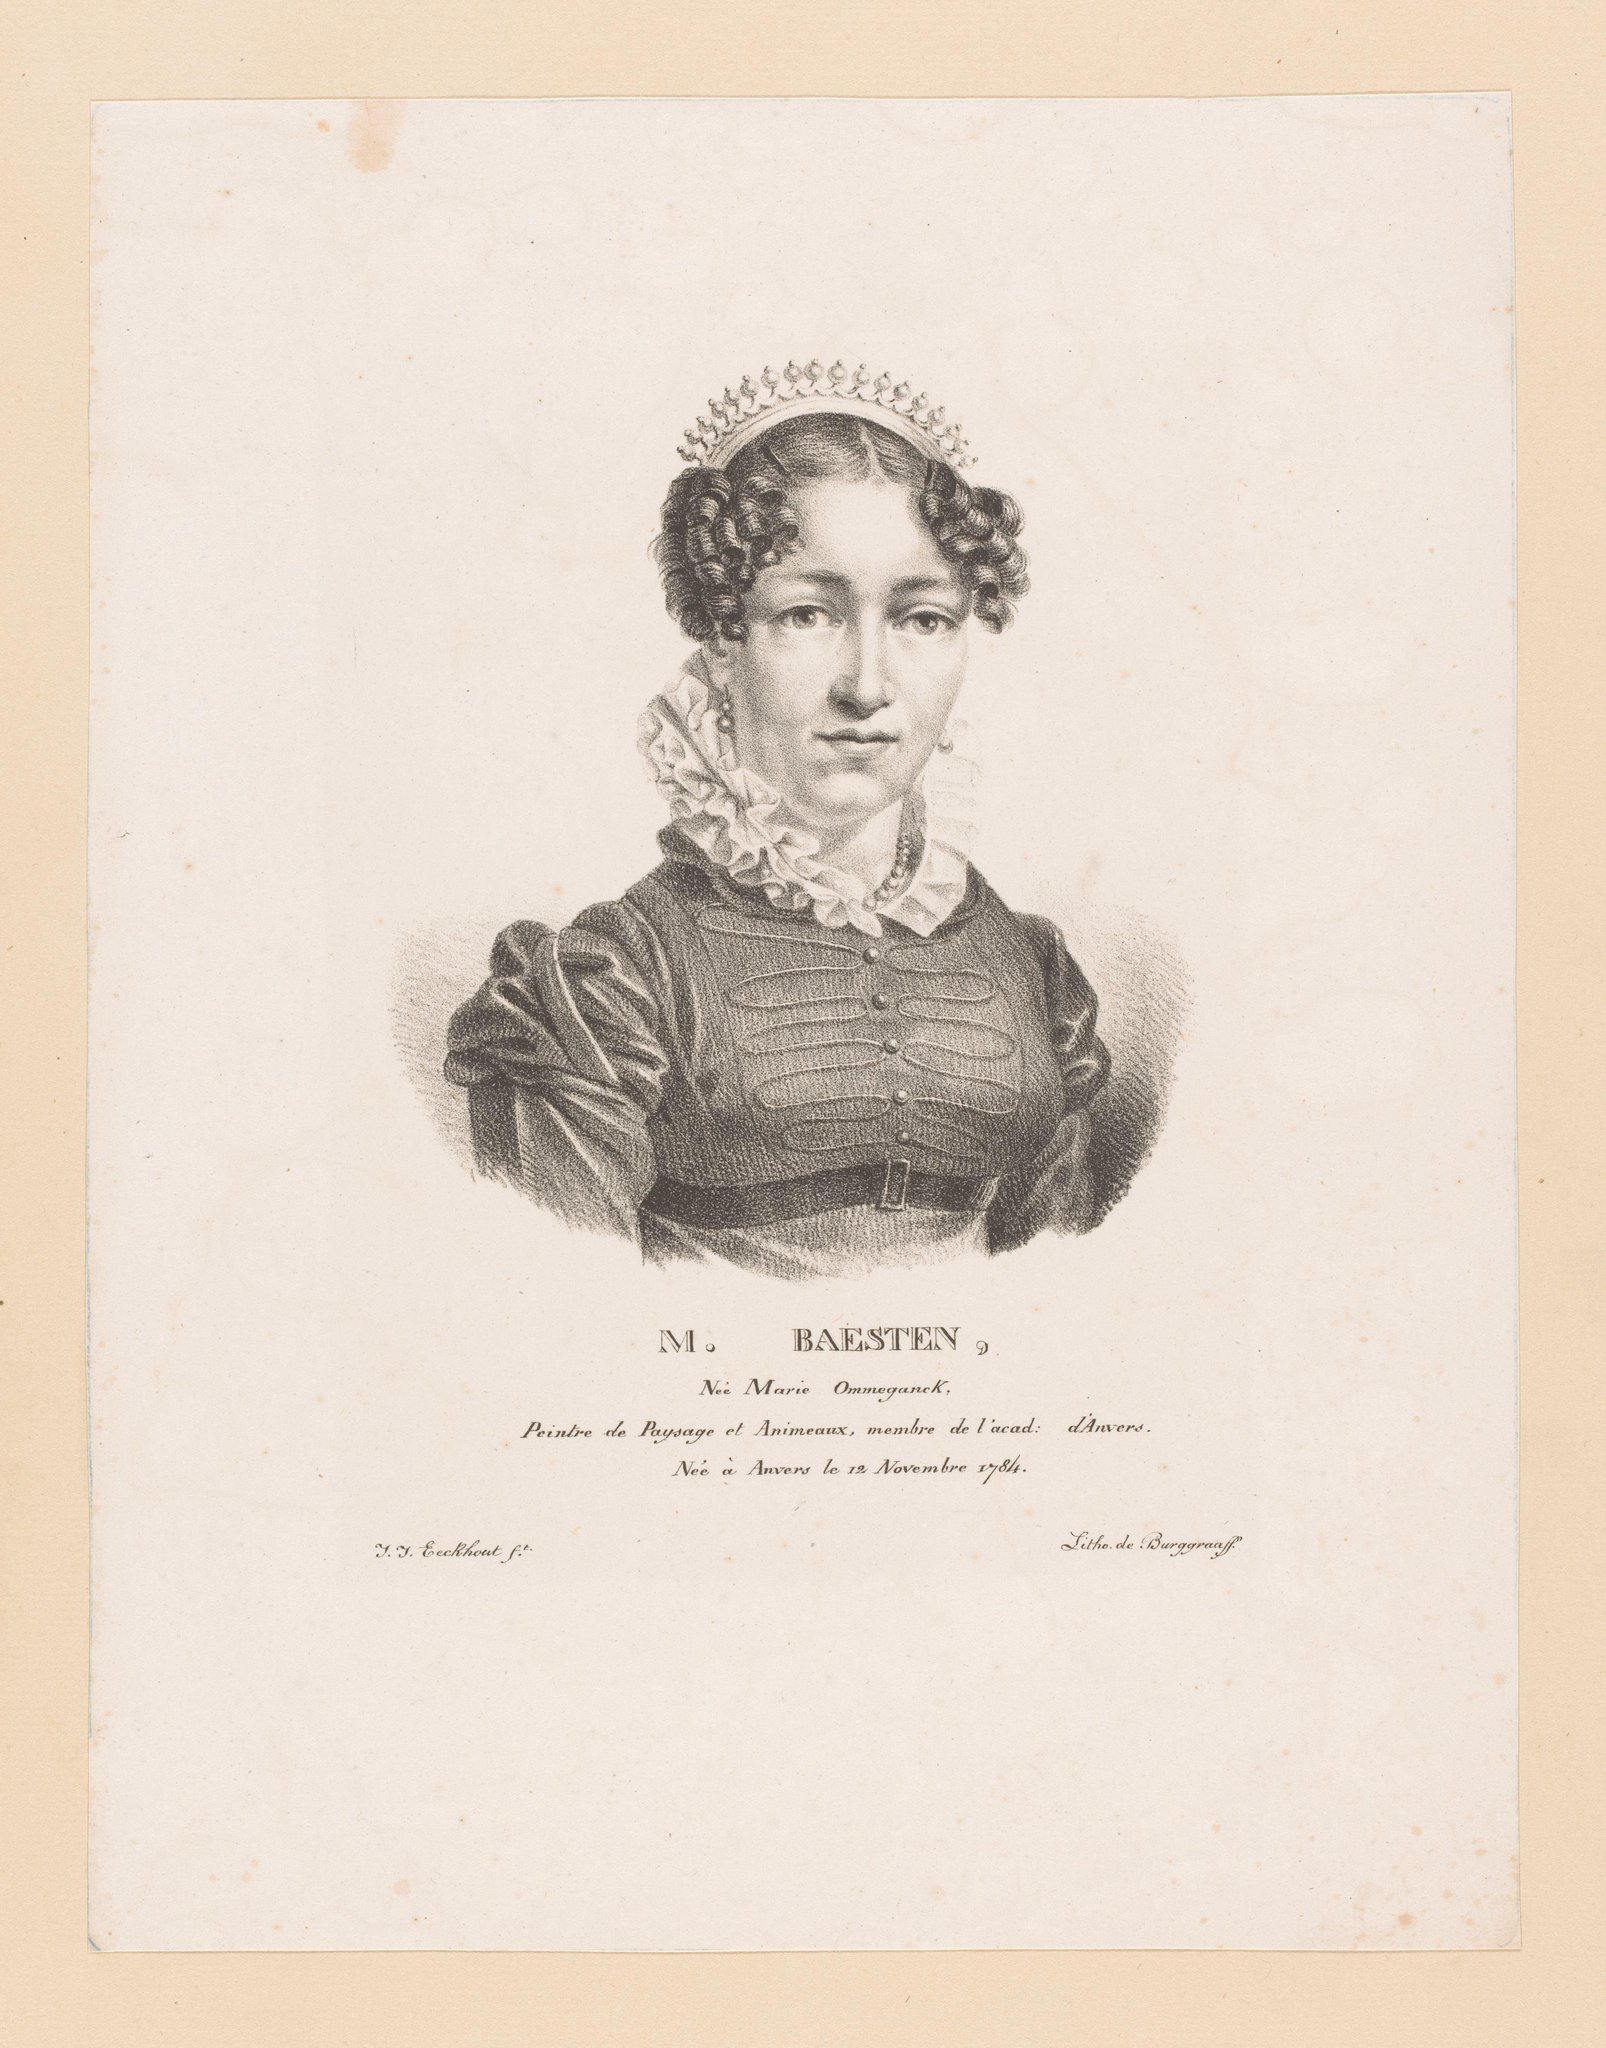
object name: print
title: M. Baesten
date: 1822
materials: paper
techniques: lithograph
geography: brussels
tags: antwerp, painter, historical persons - bb - woman, portrait, self-portrait of painter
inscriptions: collector's mark: Lugt 2228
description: Prent maakt deel uit van een serie van zestig prenten.